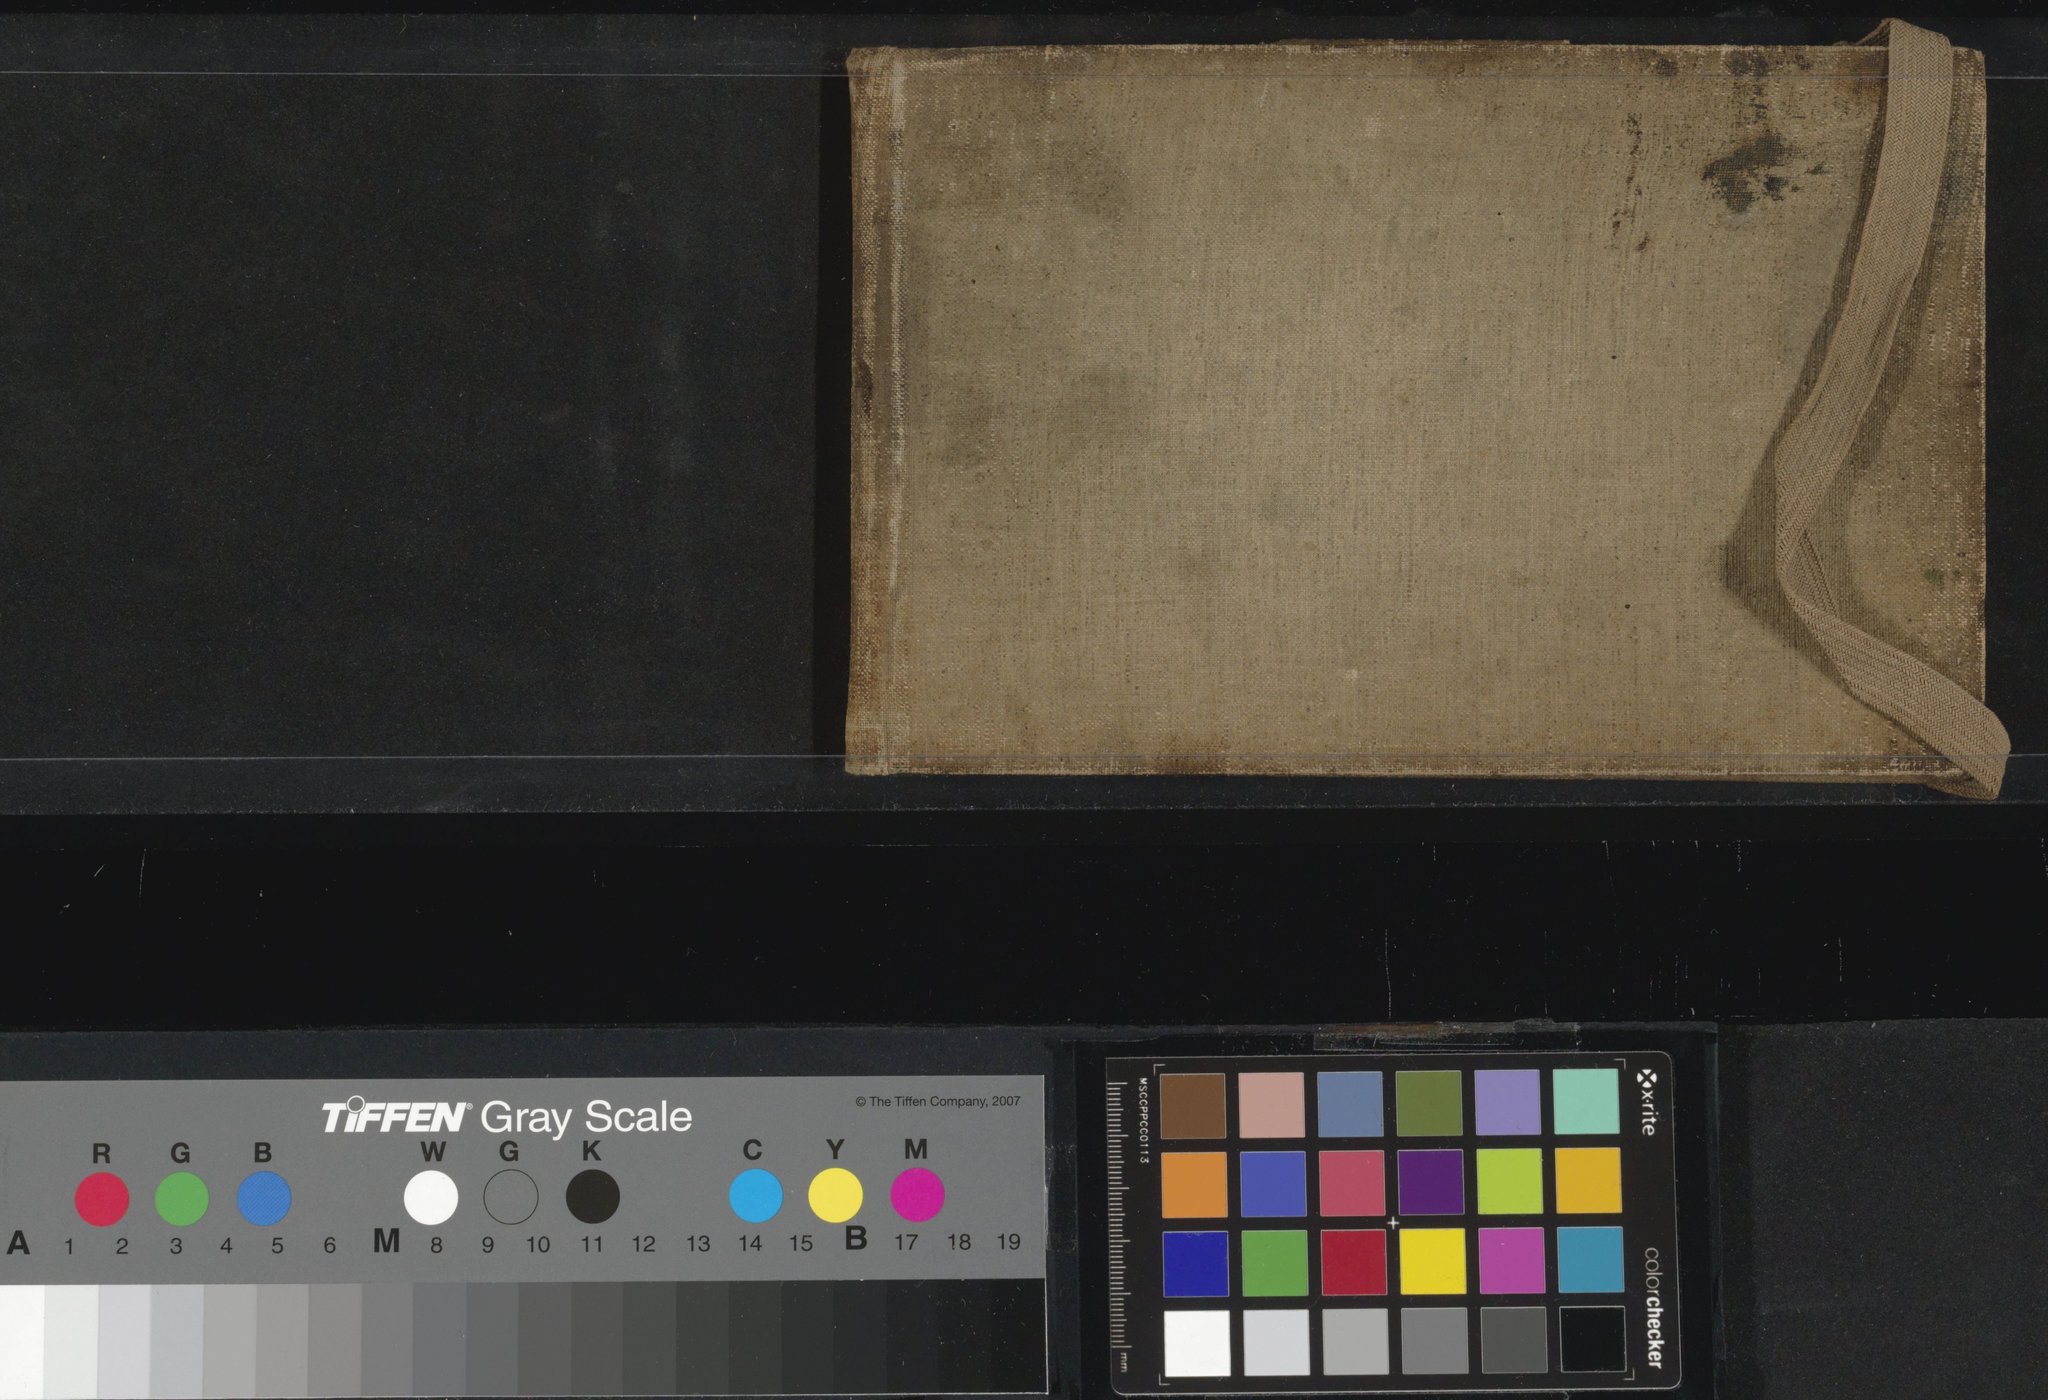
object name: sketchbook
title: Schetsboek met 46 bladen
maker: willem cornelis rip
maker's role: draughtsman, painter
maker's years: 1856-1922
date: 1874-1875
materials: cardboard, chalk, linen, paper, pencil, watercolor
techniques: brush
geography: gelderland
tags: trees, the (nude) human figure; 'corpo humano' (ripa), landscapes (+ landscape with figures, staffage), gelderland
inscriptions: signature and date: ‘W.C. Rip. ft 1874 * 75/ 21 Do[...]6’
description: Schetsboek bestaande uit 46 bladen met figuren, bomen, dieren en landschappen te Gelderland.